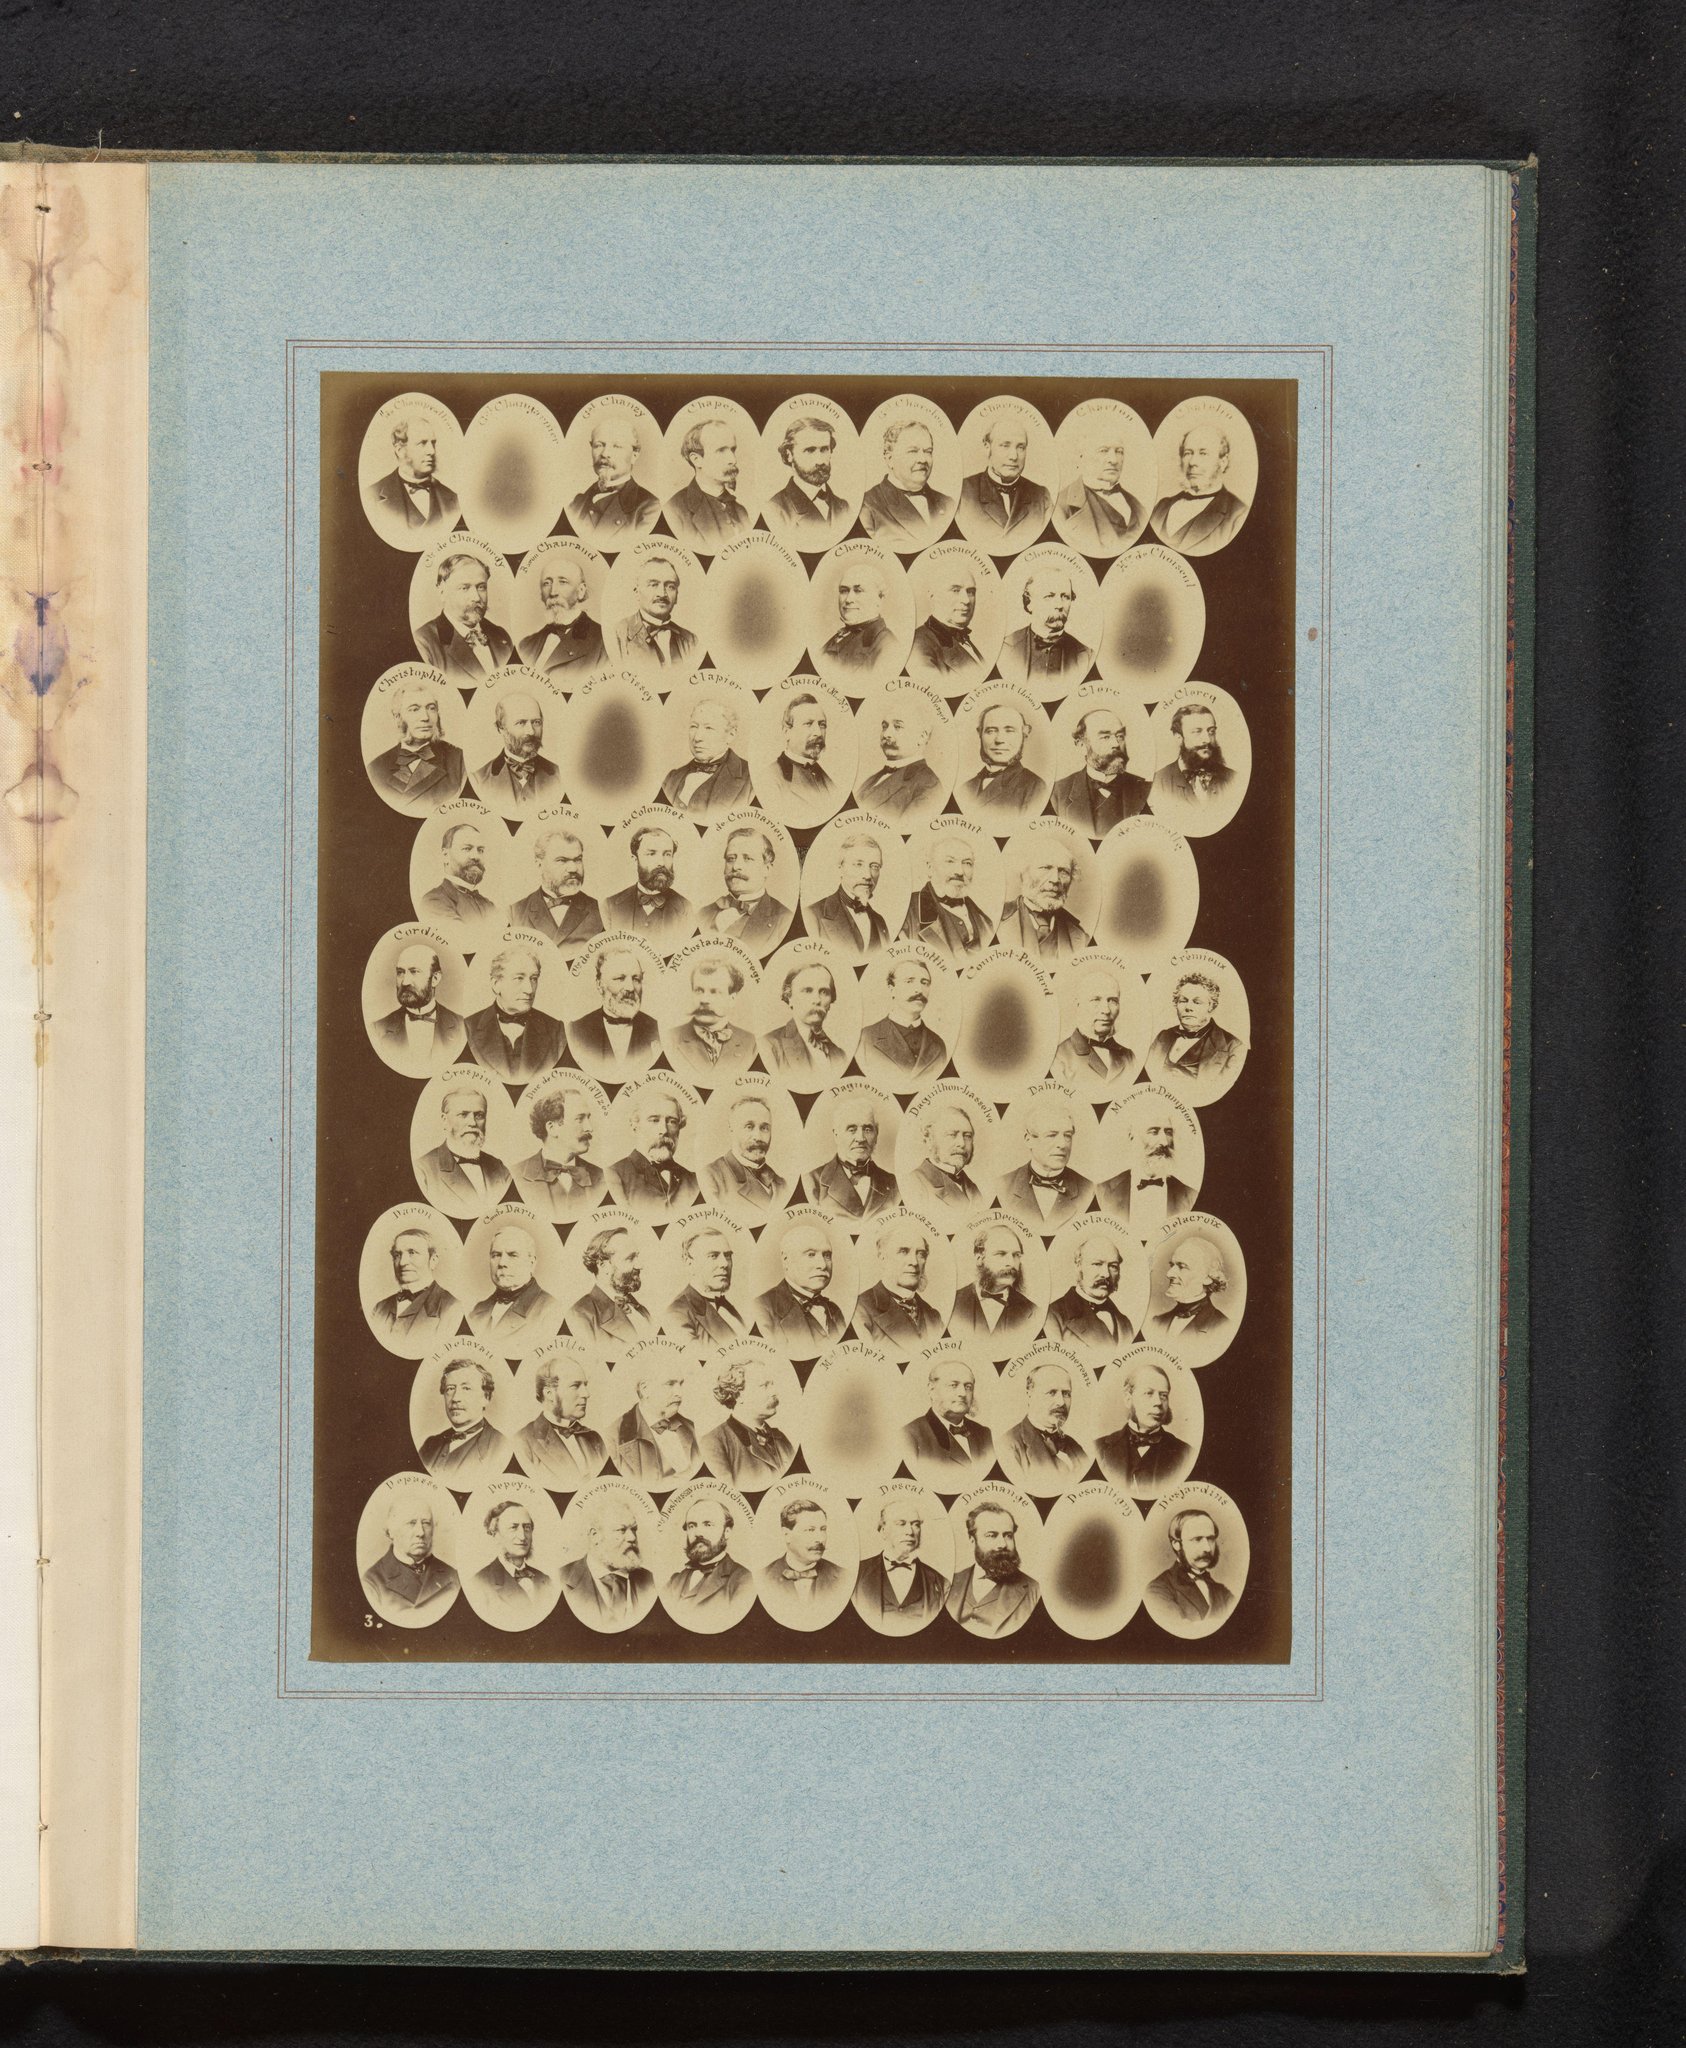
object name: photograph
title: Samengesteld groepsportret van leden van de Assembée Nationale van 1873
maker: françois marie louis franck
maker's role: fotograaf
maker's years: 1816-1906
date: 1868-1873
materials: photographic support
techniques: albumen print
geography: france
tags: politician, e.g. party leader, lower house, parliament, chamber, anonymous historical persons portrayed in a group, in a group-portrait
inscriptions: number: ‘3.’